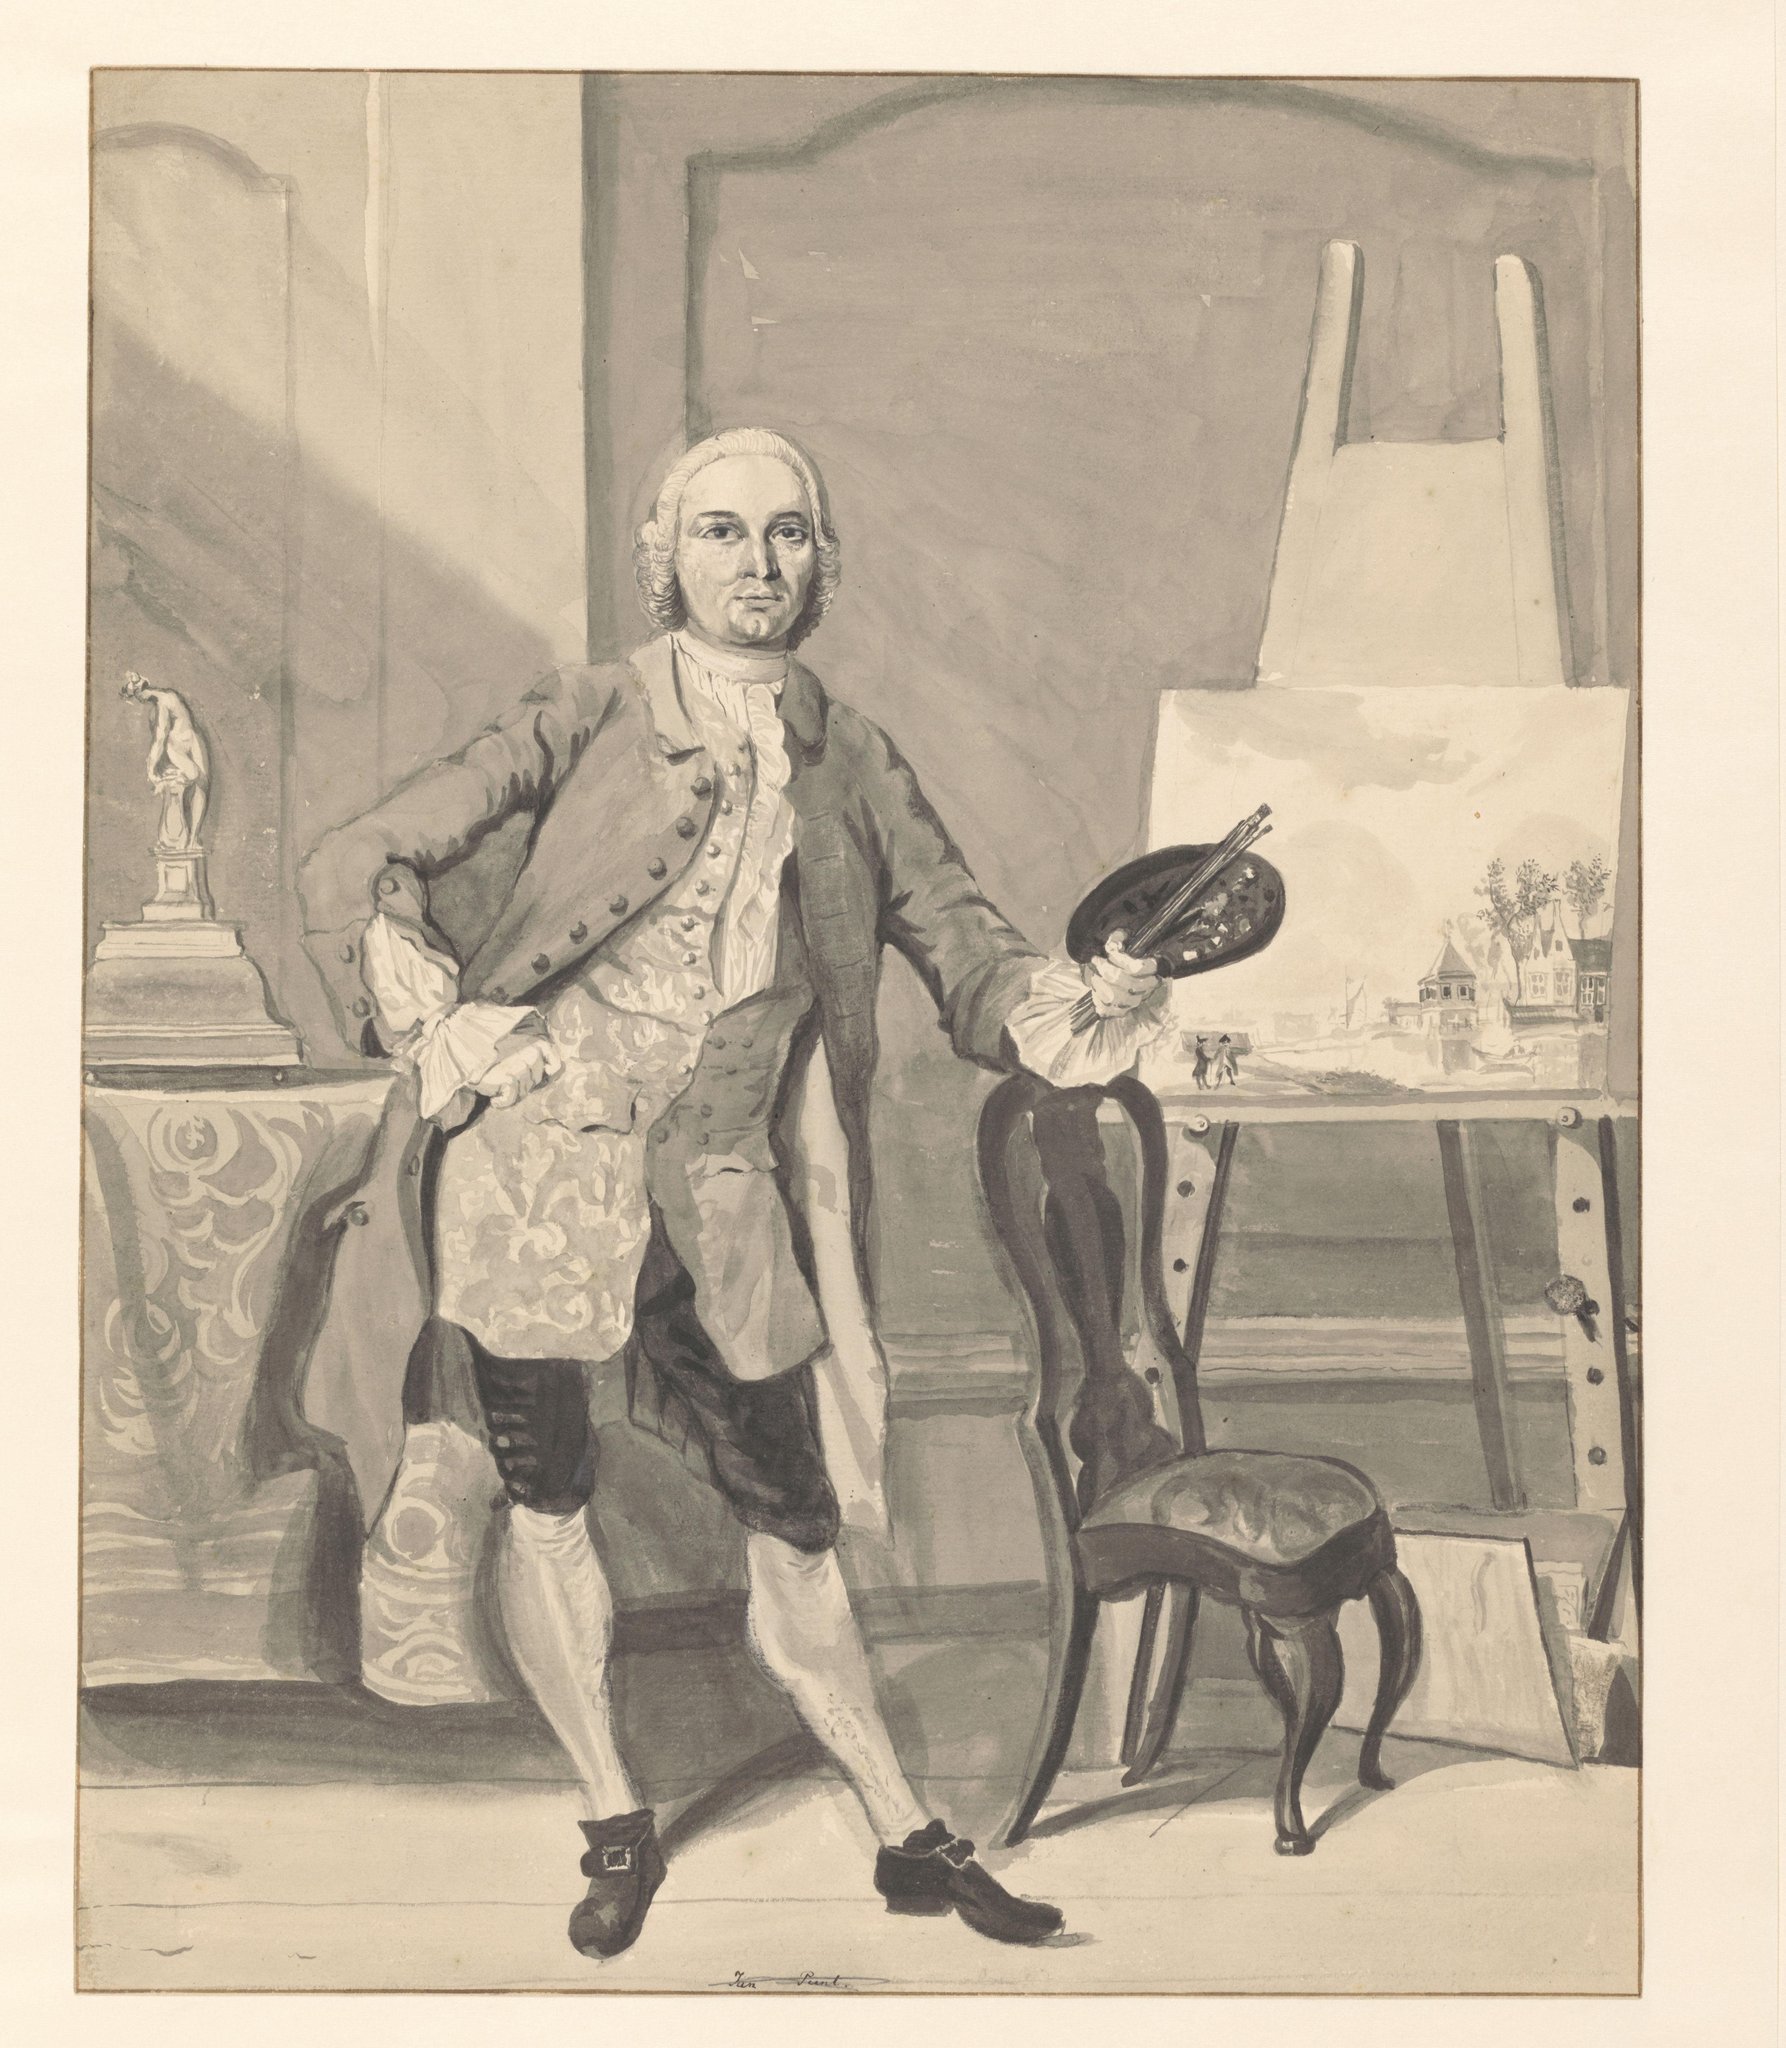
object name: drawing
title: Portret van de schilder Jan ten Compe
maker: Anonymous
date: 1734-1851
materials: chalk, paper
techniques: brush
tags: amsterdam, painter, jan ten compe, historical persons, portrait, self-portrait of painter, portrait, self-portrait of artist